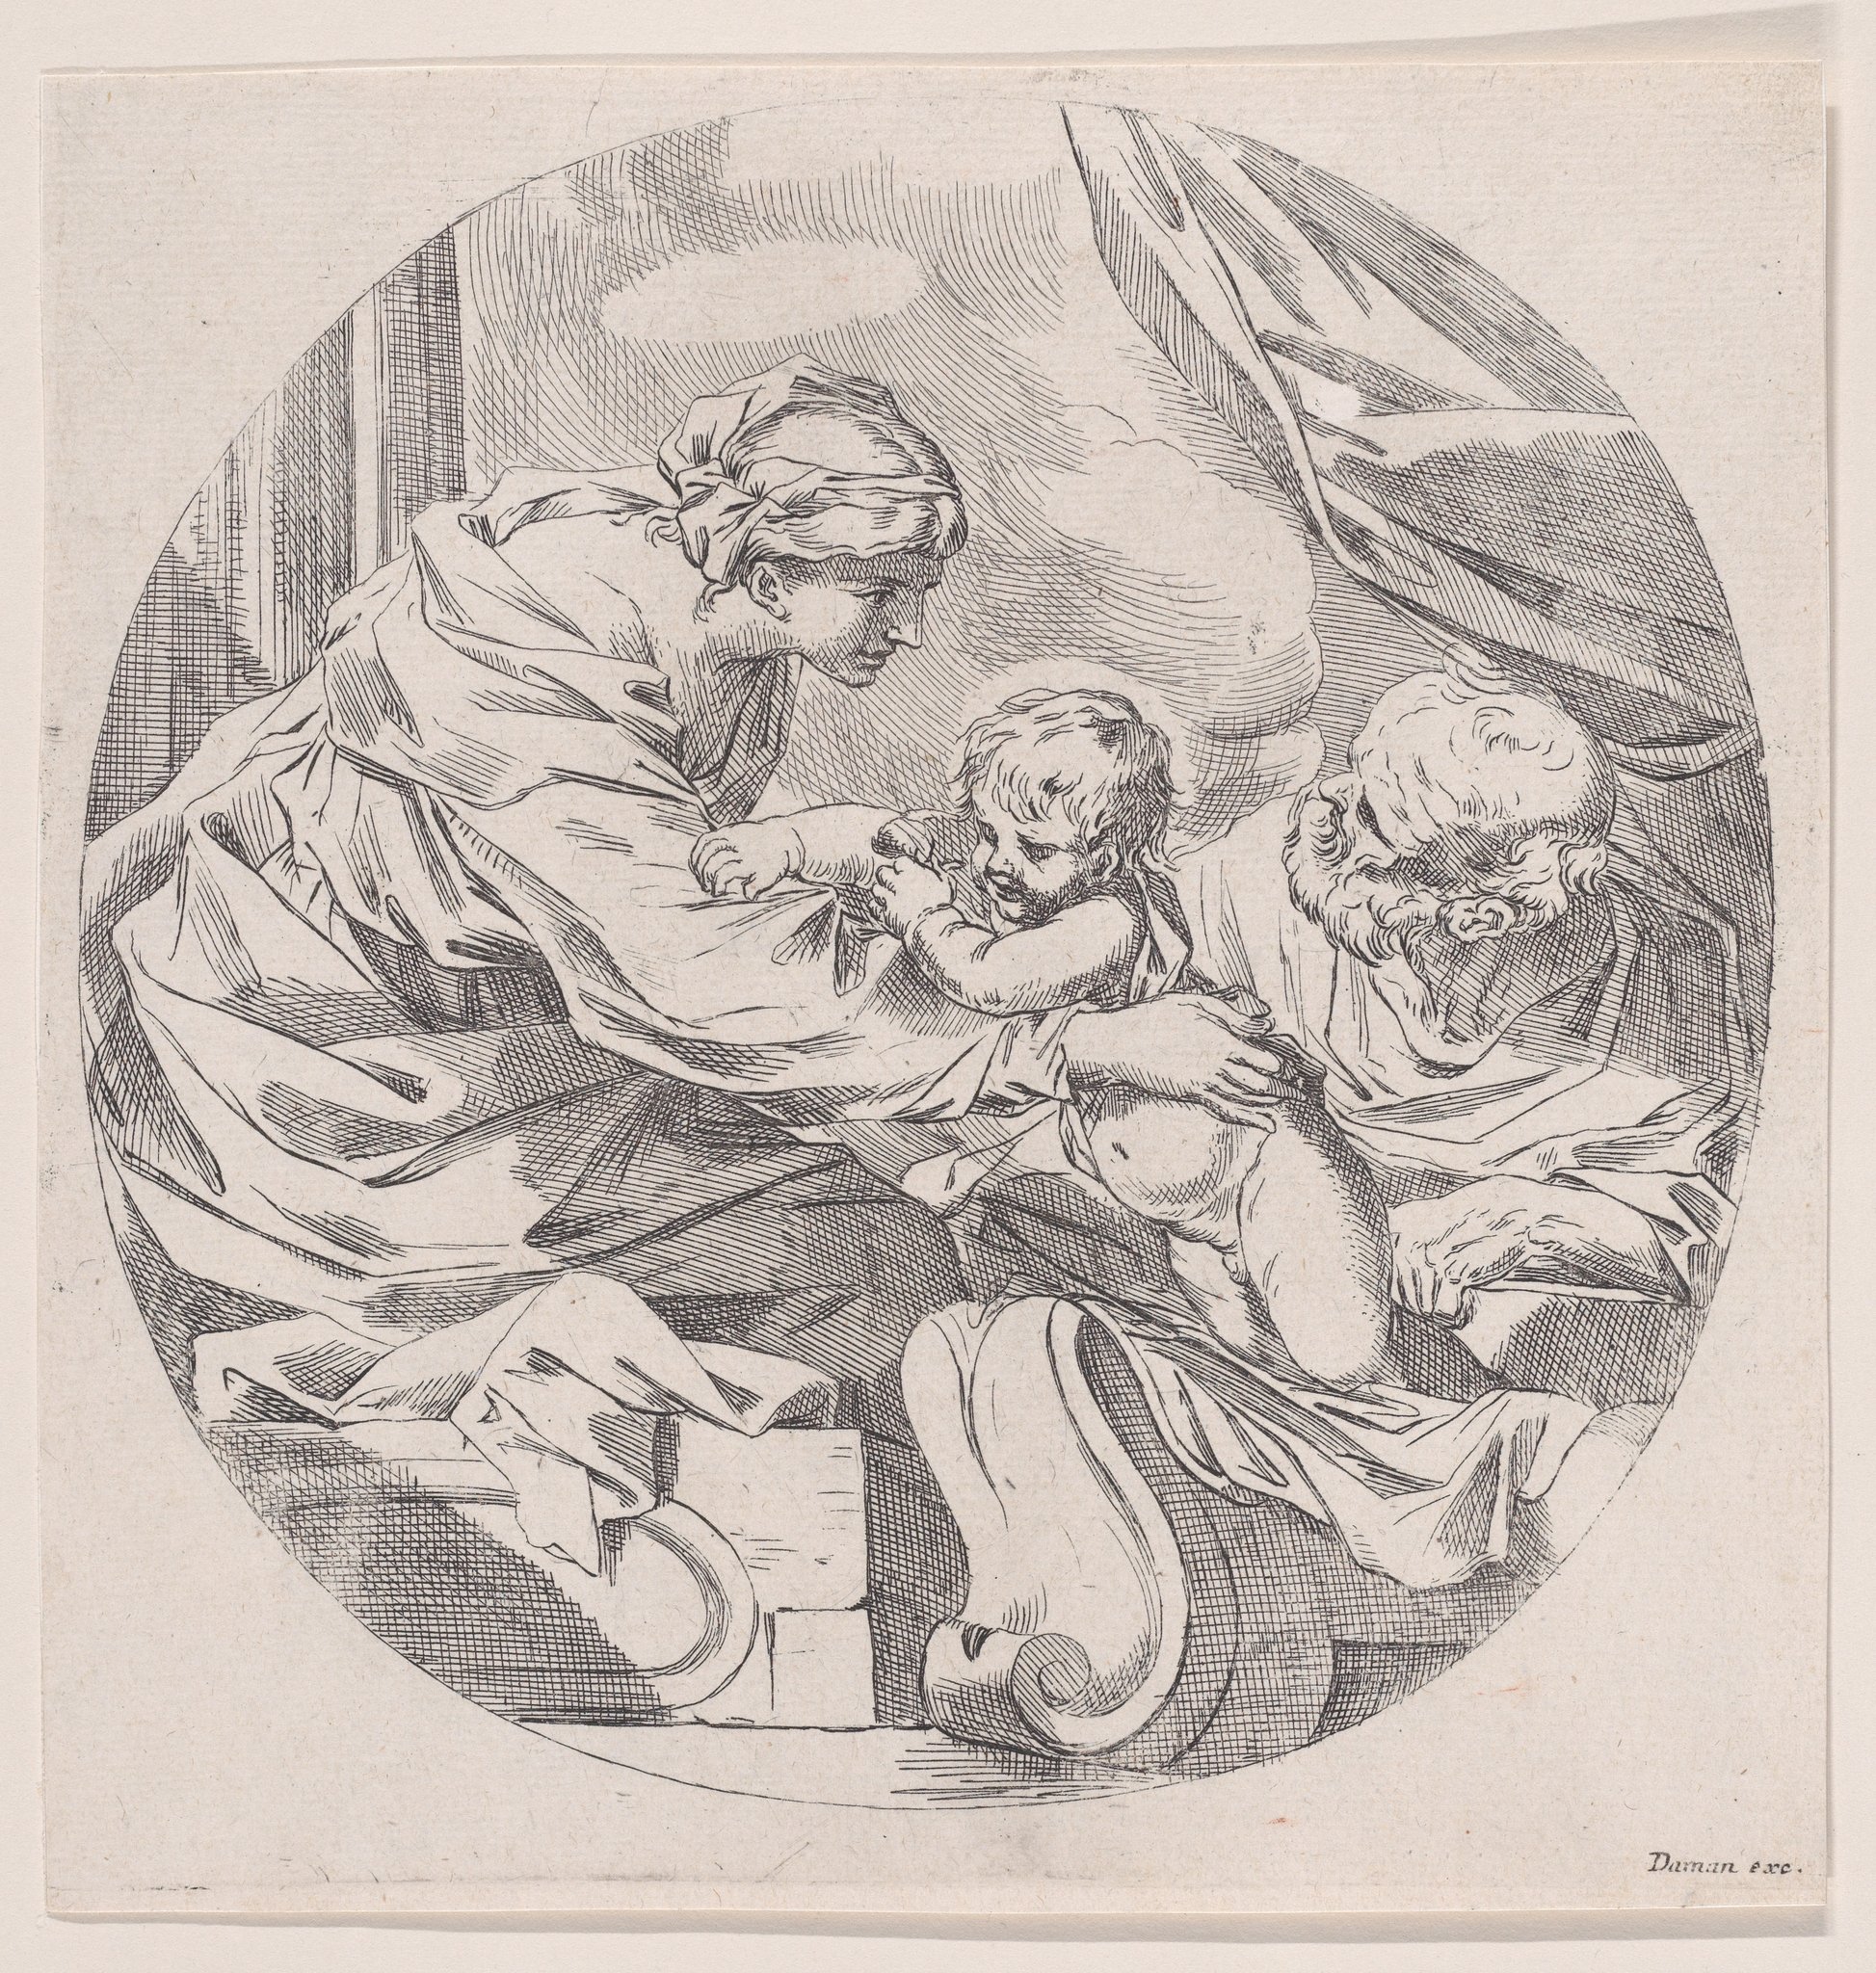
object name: print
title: The Holy Family, in a circle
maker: anonymous, italian, 17th century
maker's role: artist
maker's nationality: italian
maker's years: 1600-1700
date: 1640-1660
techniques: etching